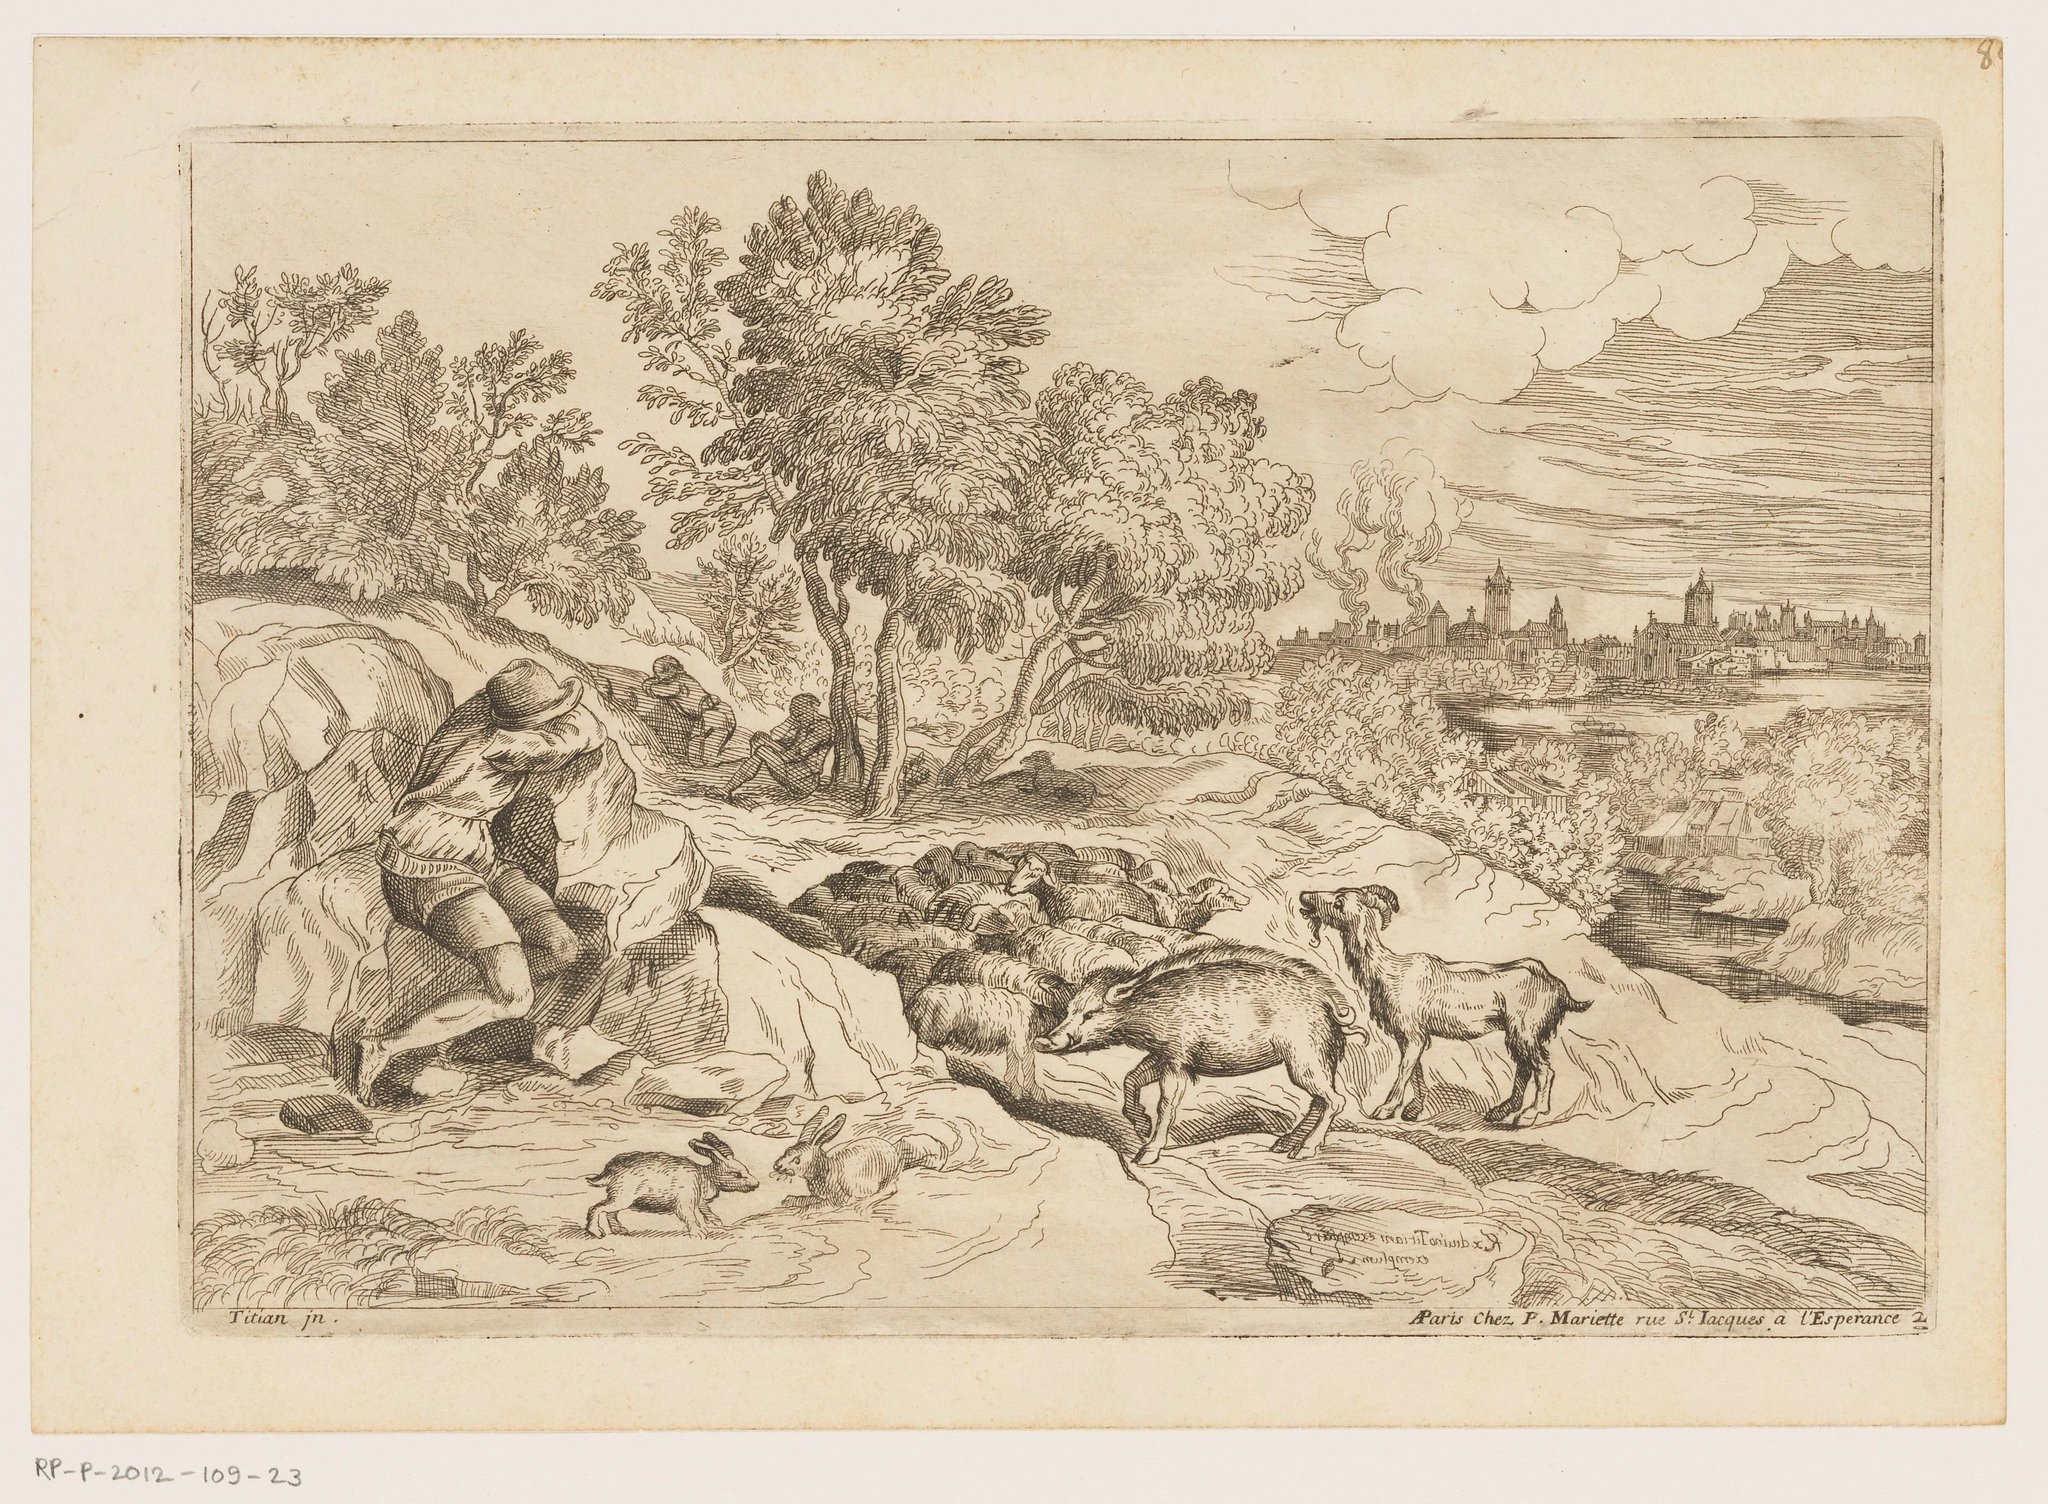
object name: print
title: Landschappen naar Titiaan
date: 1663-1726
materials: paper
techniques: etching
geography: paris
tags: (traveller) resting in the open air, resting, herd, flock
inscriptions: collector's mark: Lugt 2228, collector's mark: Lugt 3474, collector's mark: Lugt 3473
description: Maakt deel uit van vierentwintigdelige serie met landschappen naar Titiaan en Campagnola.